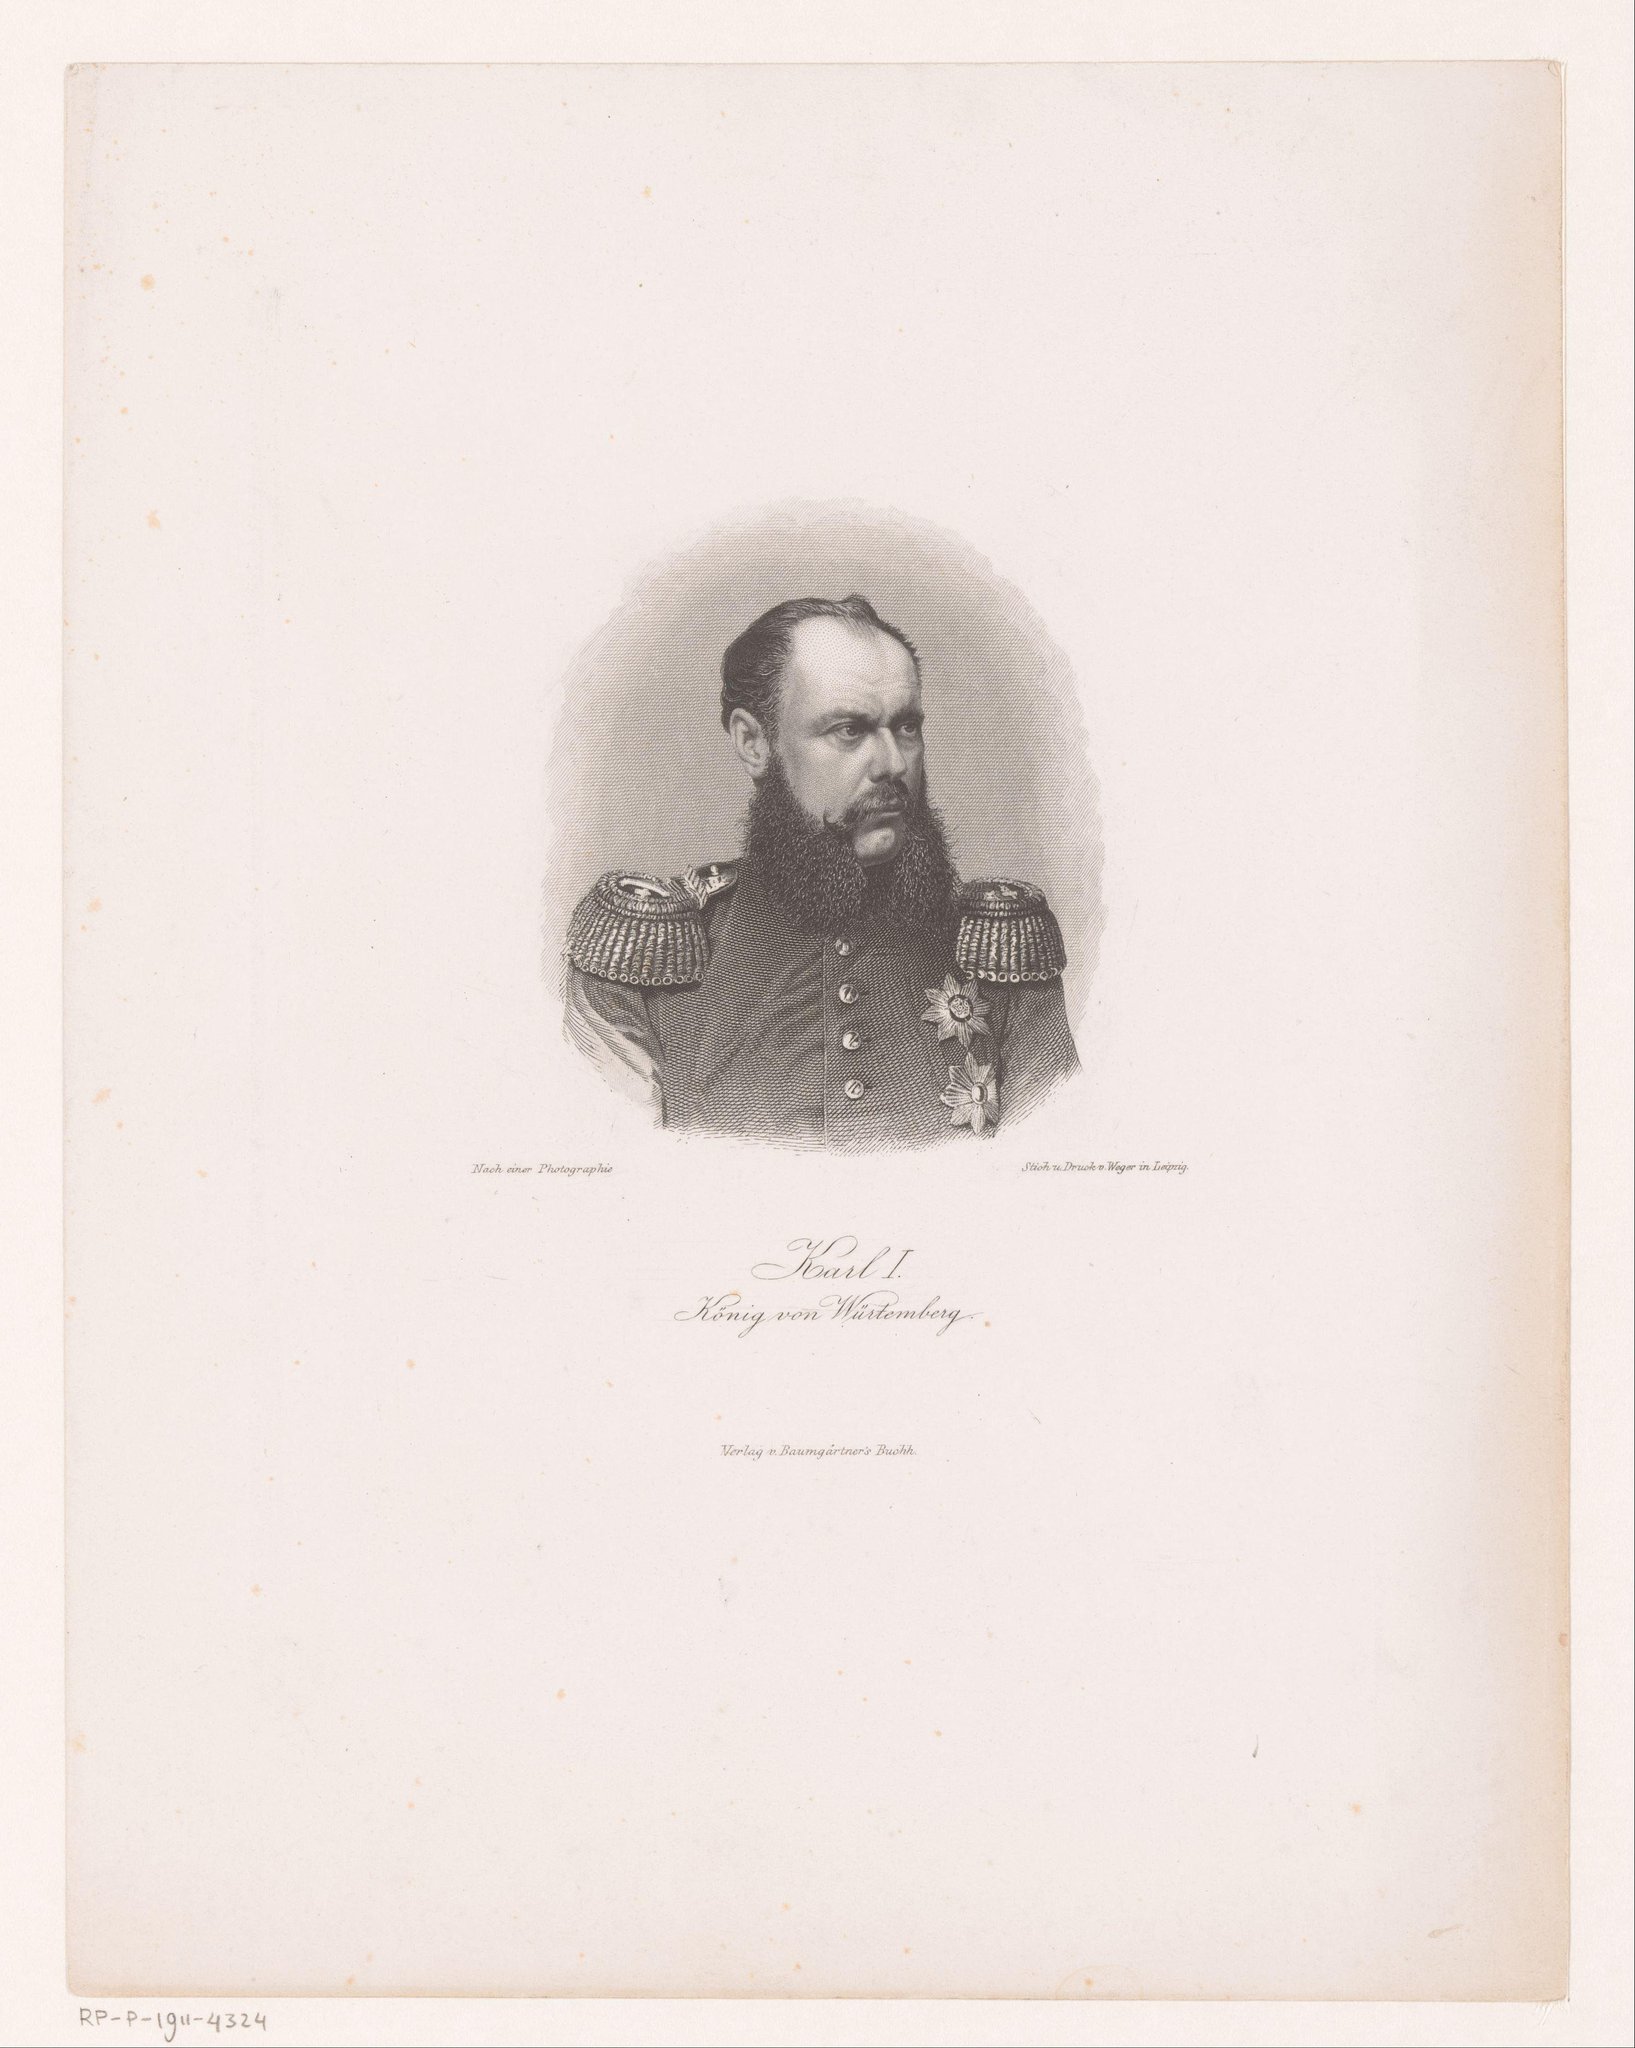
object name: print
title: Portret van Karl I, koning van Württemberg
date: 1864-1892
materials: paper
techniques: engraving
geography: leipzig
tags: historical persons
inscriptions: collector's mark: Lugt 2228